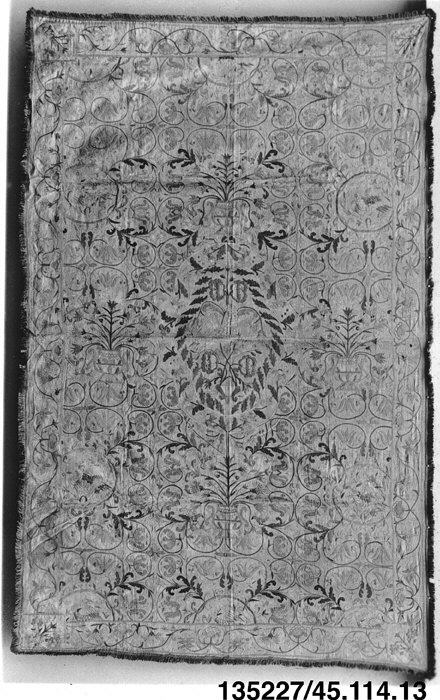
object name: hanging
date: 1601-1800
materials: linen, silk